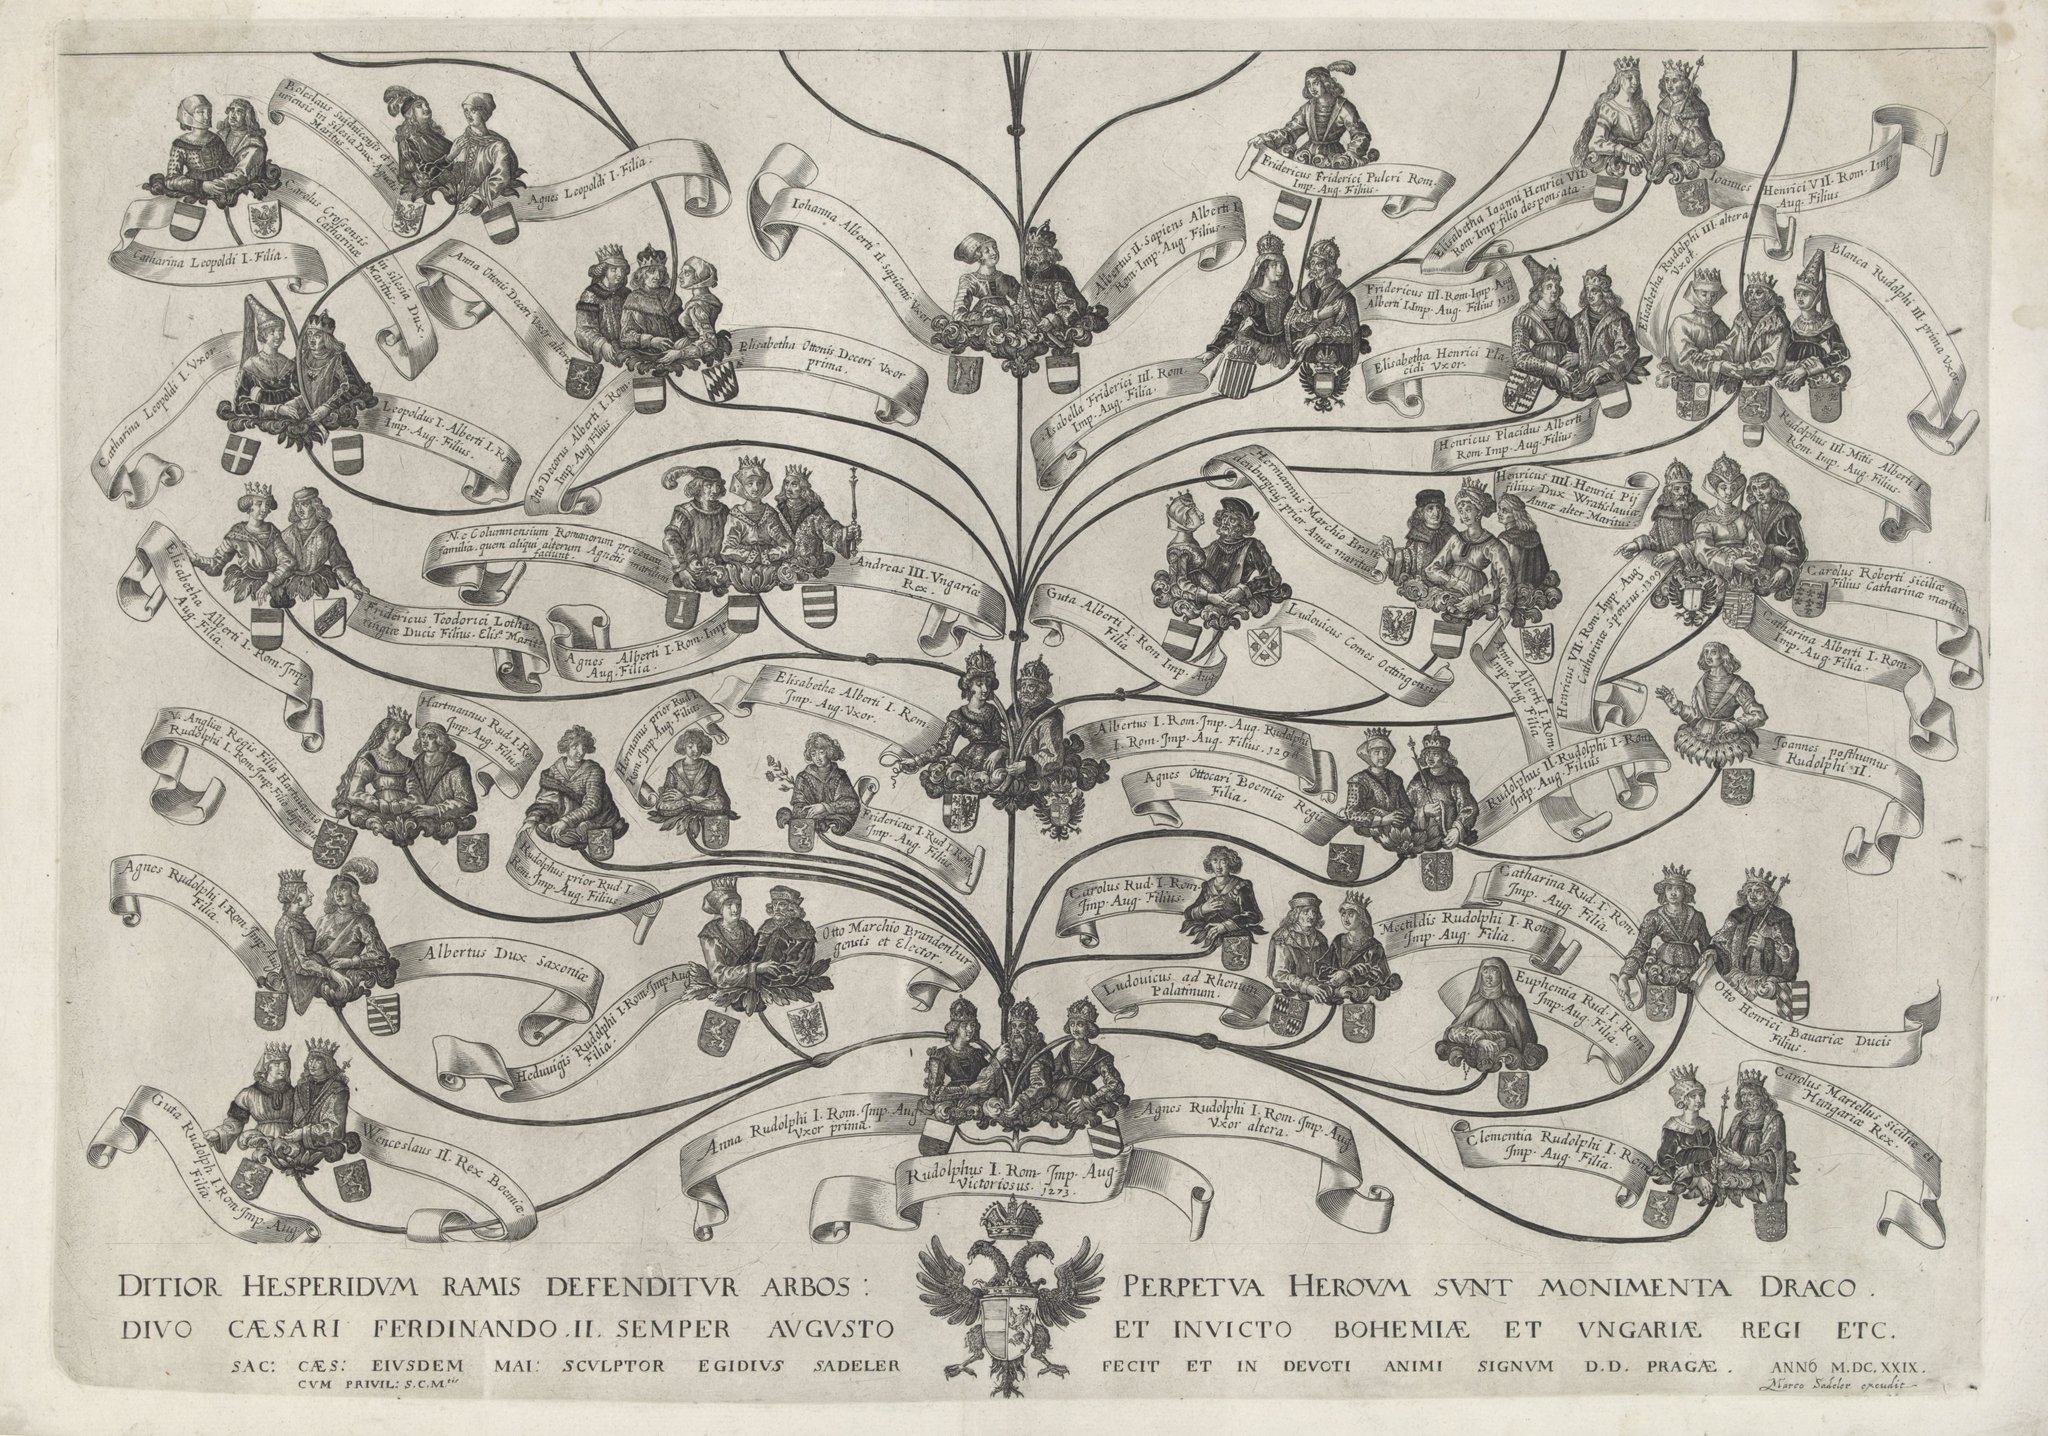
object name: titelprent, frontispice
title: Stamboom van het Habsburgse huis (onderste blad)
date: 1629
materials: paper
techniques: engraving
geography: prague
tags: family lineage, pedigree, genealogical tree or table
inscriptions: collector's mark: Lugt 2228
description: De prent behoort tot een serie bestaande uit zes prenten, waarvan één titelprent. De laatste prent is van de hand van een anonieme kunstenaar en de overige prenten zijn vervaardigd door Aegidius Sadeler.